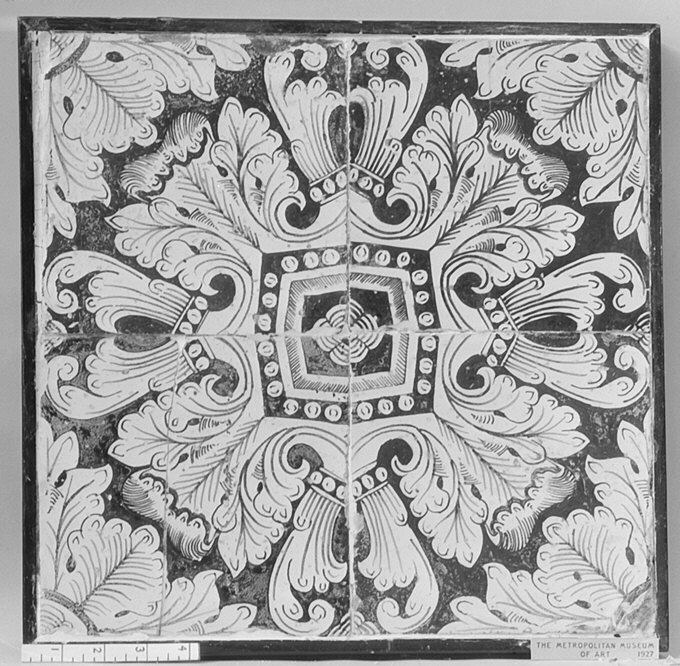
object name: tile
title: Panel of tiles (4)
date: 1725-1775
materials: earthenware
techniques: glazing